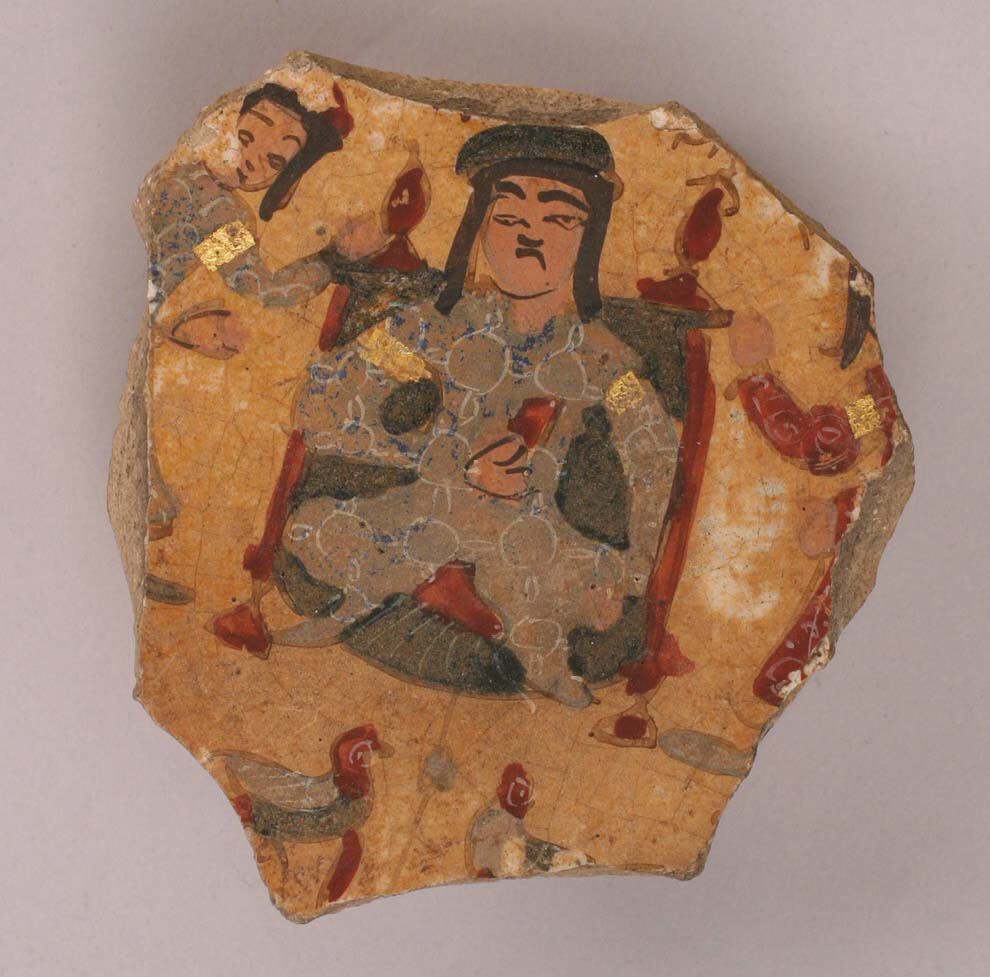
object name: fragment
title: Fragment of a Bowl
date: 1101-1300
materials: stonepaste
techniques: overglaze, painting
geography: iran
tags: men